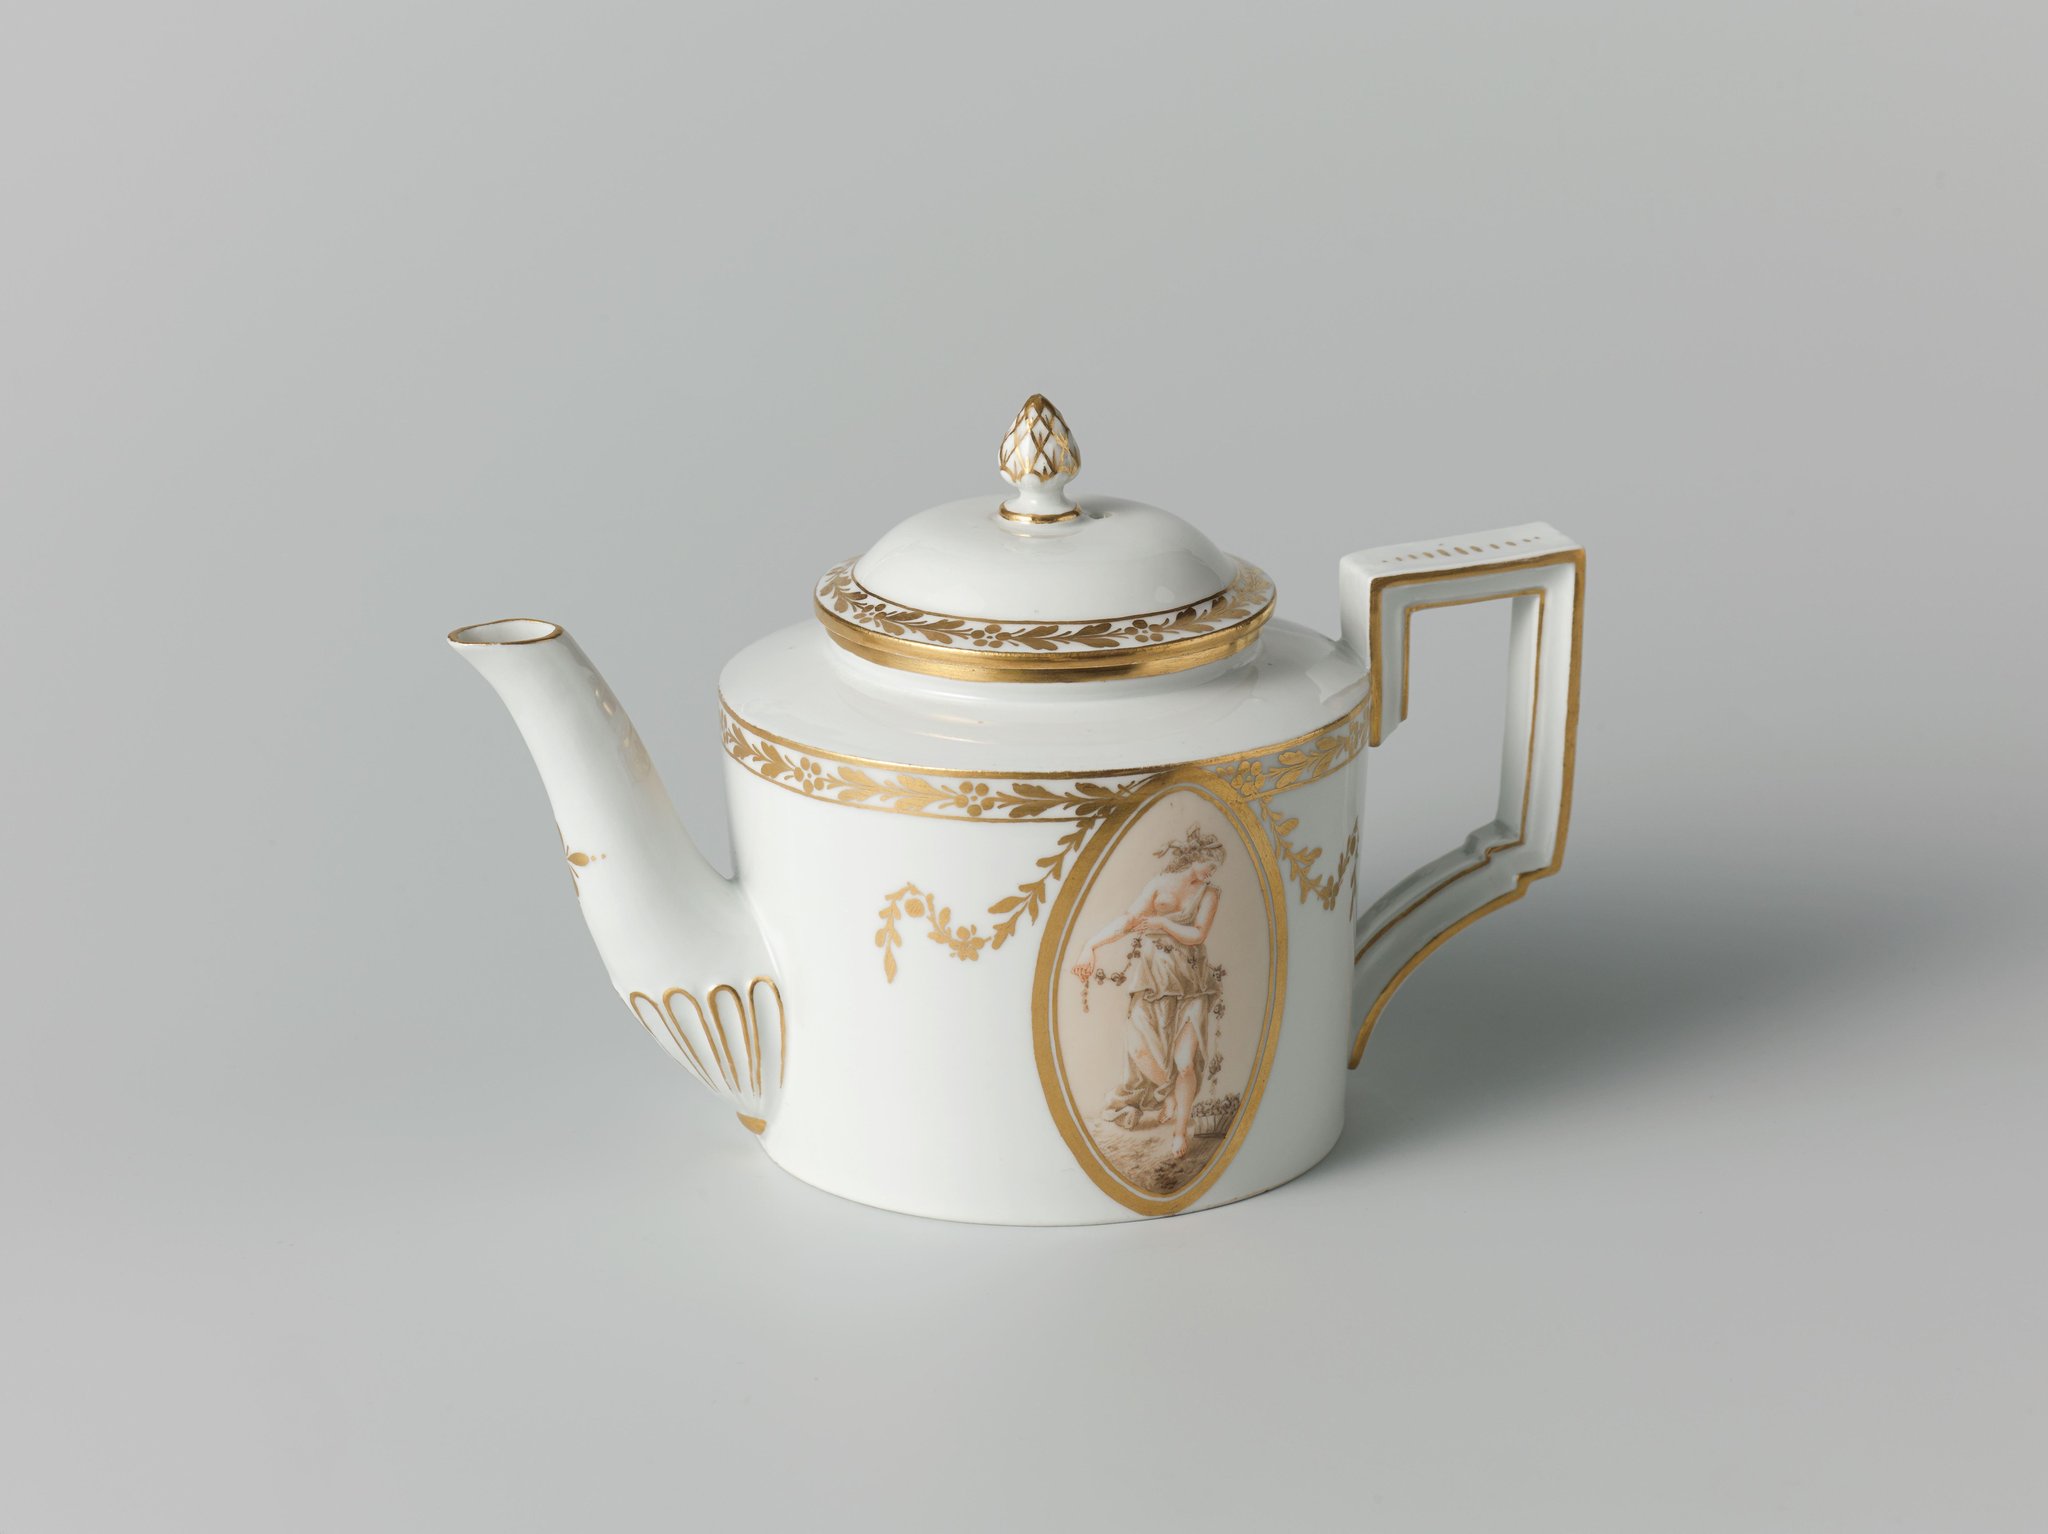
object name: service set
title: Teapot with a woman in a medallion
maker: carl heinrich böcker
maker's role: porseleinmodelleur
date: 1785-1795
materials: glaze, gold, paint, porcelain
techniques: firing, forming, gilding, turning, vitrification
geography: furstenberg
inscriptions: mark: ‘F-1/ BÖ/ D2’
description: Theepot van porselein met een cilindrisch lichaam, gebogen tuit en hoekig oor, beschilderd op het glazuur in sepia en goud. Op de buik tweemaal een medaillon met een klassiek geklede vrouw, de één met een bloemslinger en de ander leunend op een kolom. Boven de medaillons een guirlande met daarboven een band met een bladrank. De basis van de tuit is gemodelleerd in een bloem, met daarboven een geschilderde rozet. Het oor met gouden lijnen, stippen en bloemmotieven. Gouden lijn op de nek. Gemerkt op de onderzijde met F-I en BÖ en D2.